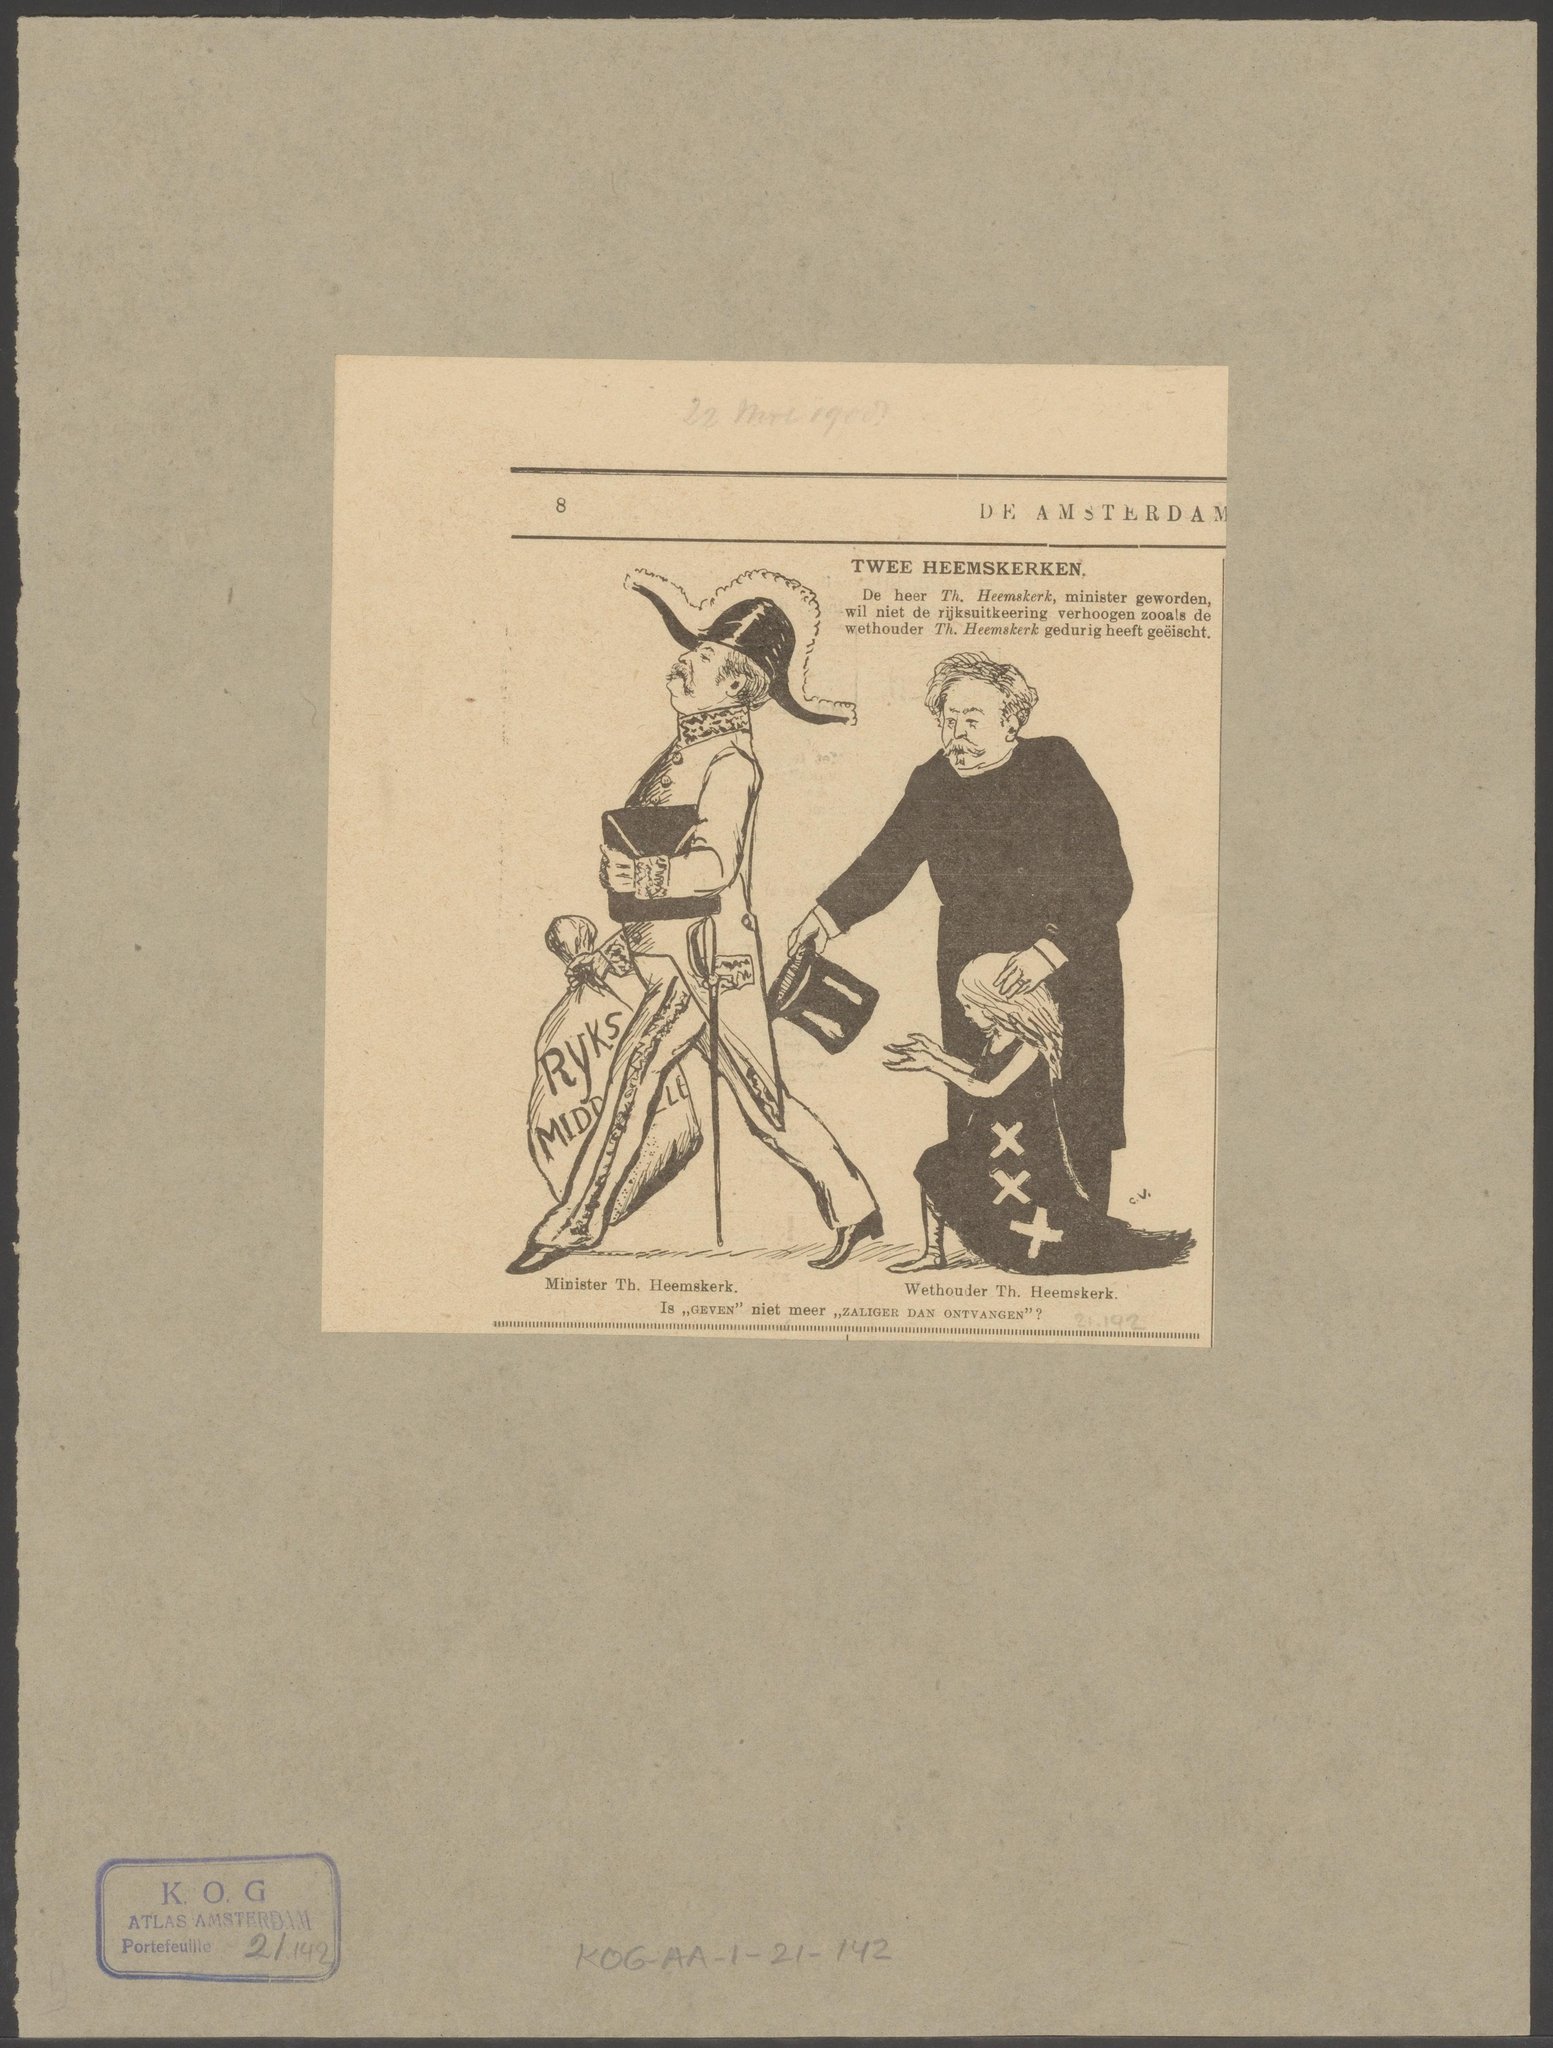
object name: photomechanical print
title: Twee Heemskerken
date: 1908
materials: paper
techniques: letterpress printing, line block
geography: netherlands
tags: amsterdam, utrecht, personification of a city, town-patron(ess), politician, e.g. party leader, beggar, clothes, costume, political caricatures and satires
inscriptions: signature: ‘c.v.’, collector's mark: Lugt 1641b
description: Minister Heemskerk in Frans Keizerlijk kostuum, wethouder Heemskerk met geknield kind met drie Andreaskruizen op het gewaad. Onderwerpsrubriek binnen de Atlas Amsterdam: Belastingen.